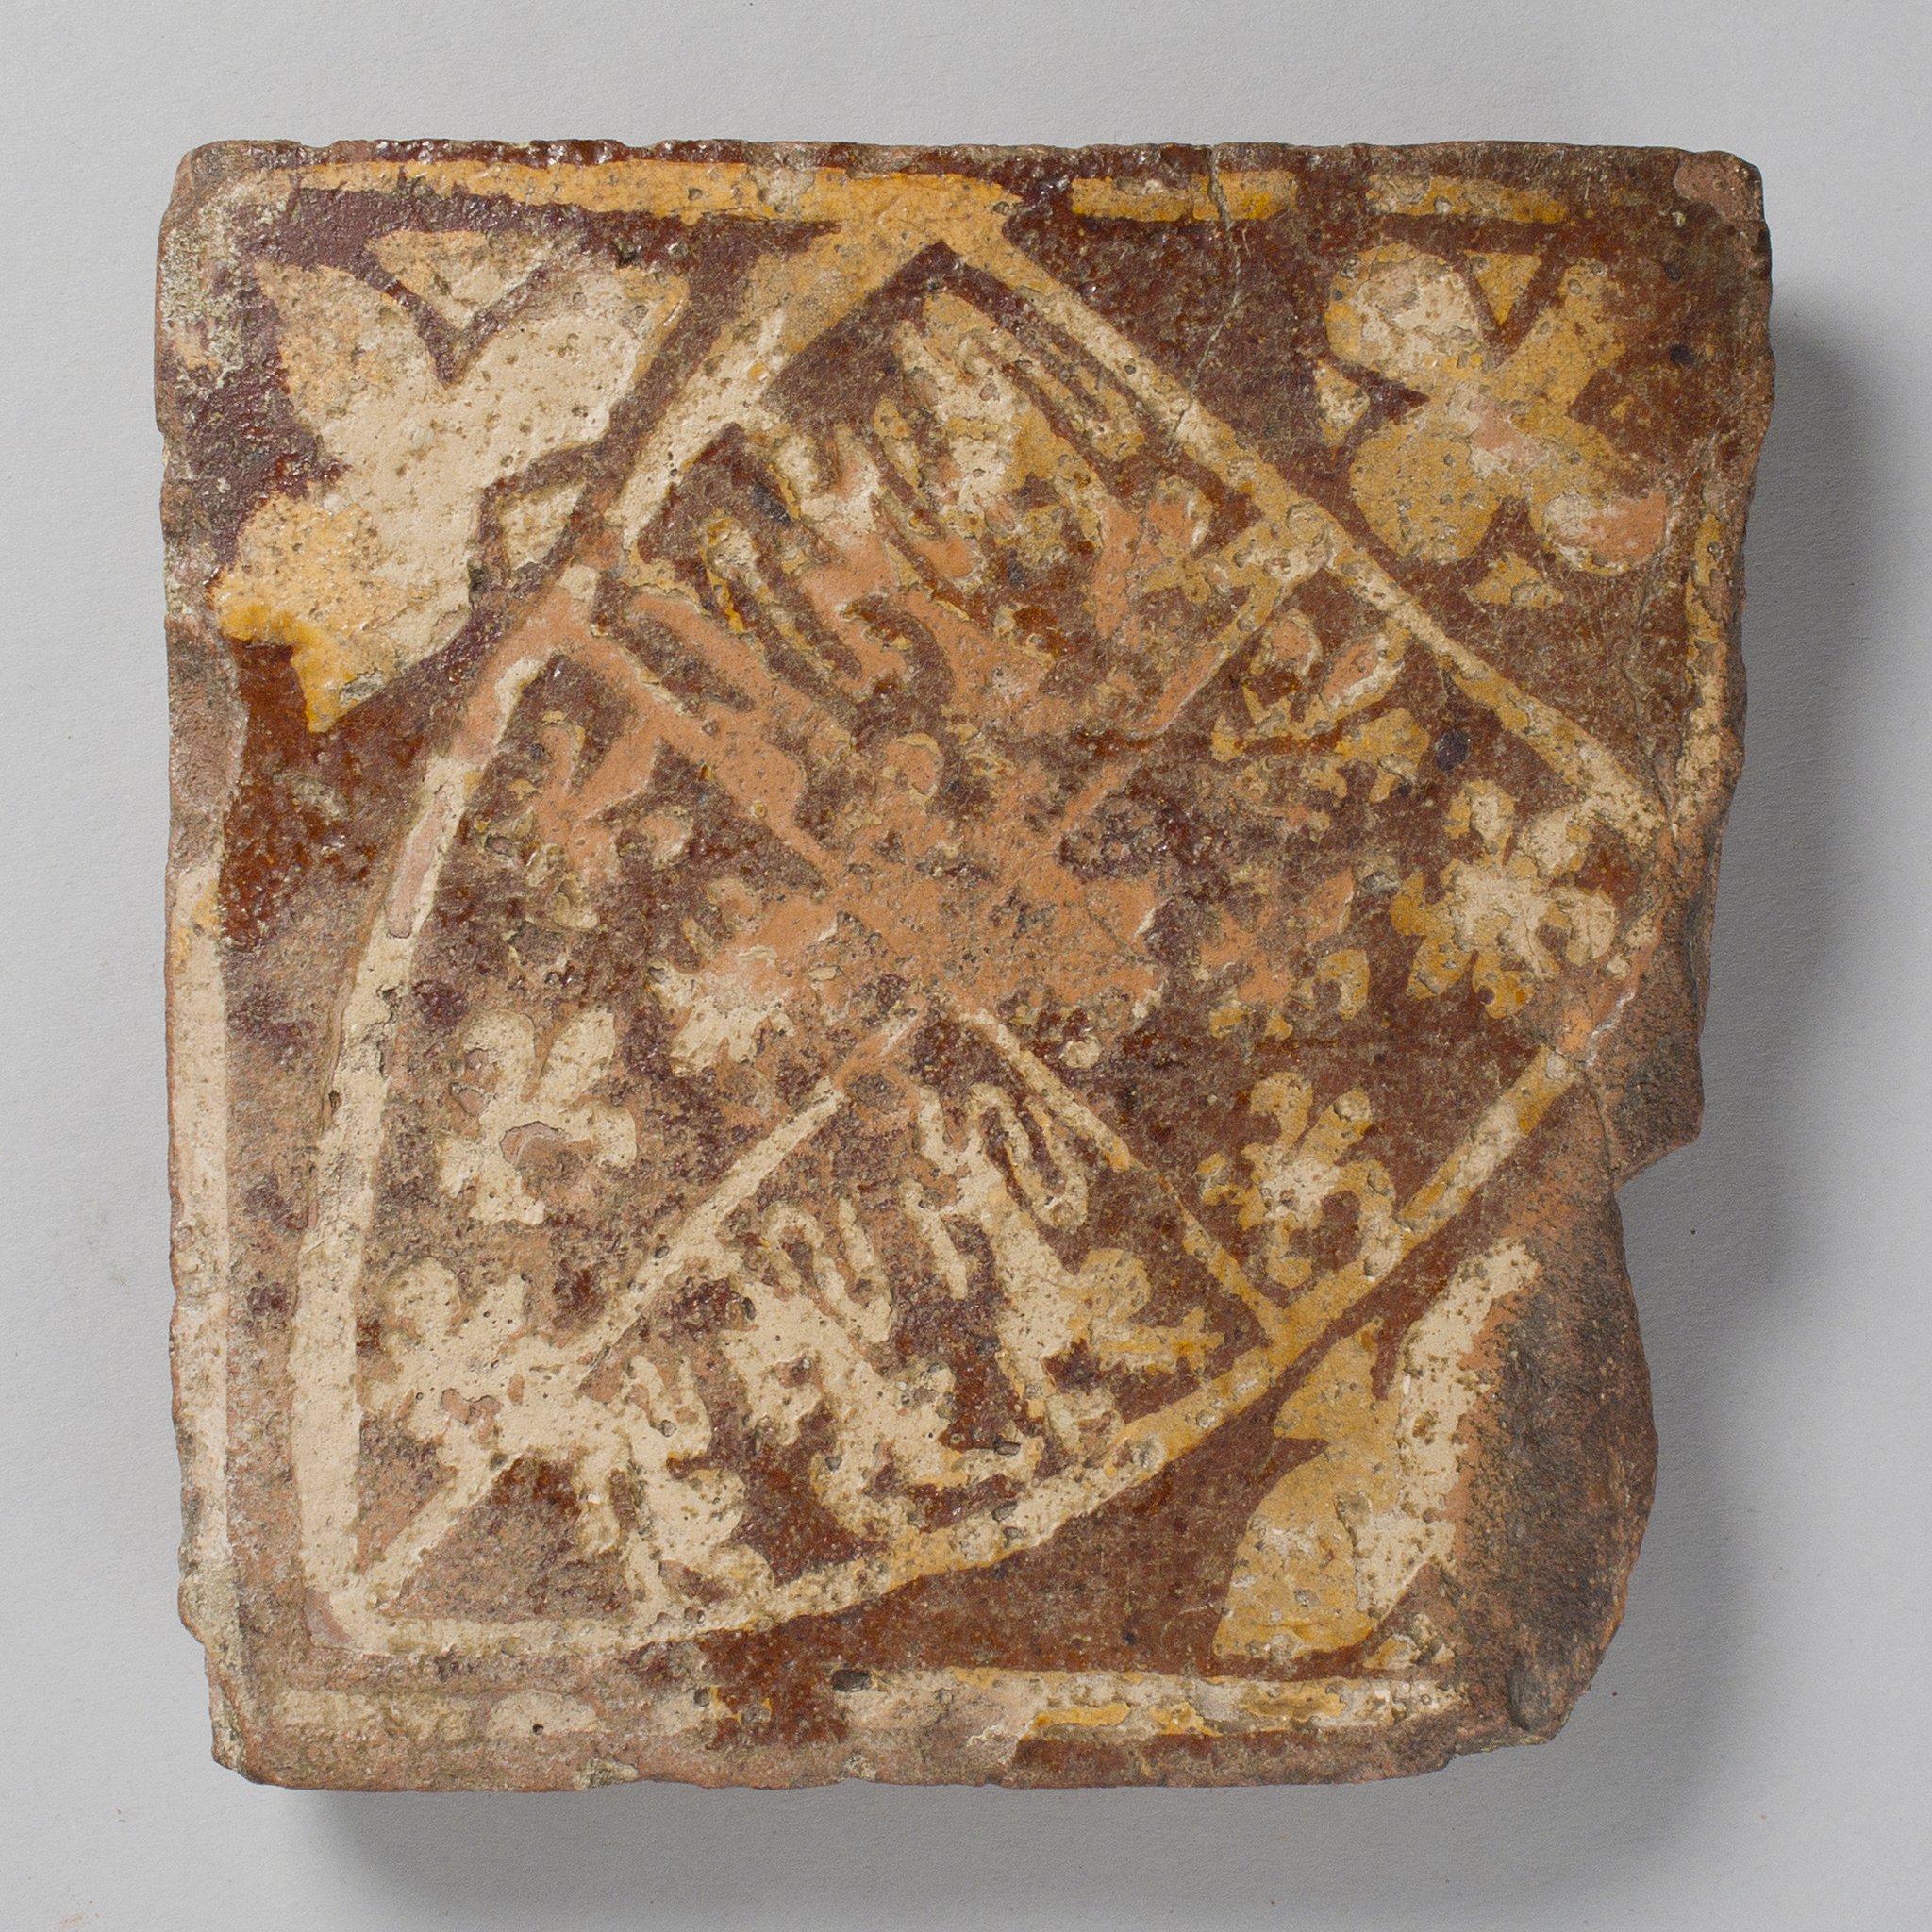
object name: tile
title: Two-Colored Tile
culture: british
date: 1367-1400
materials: earthenware, glaze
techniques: firing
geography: england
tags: coat of arms